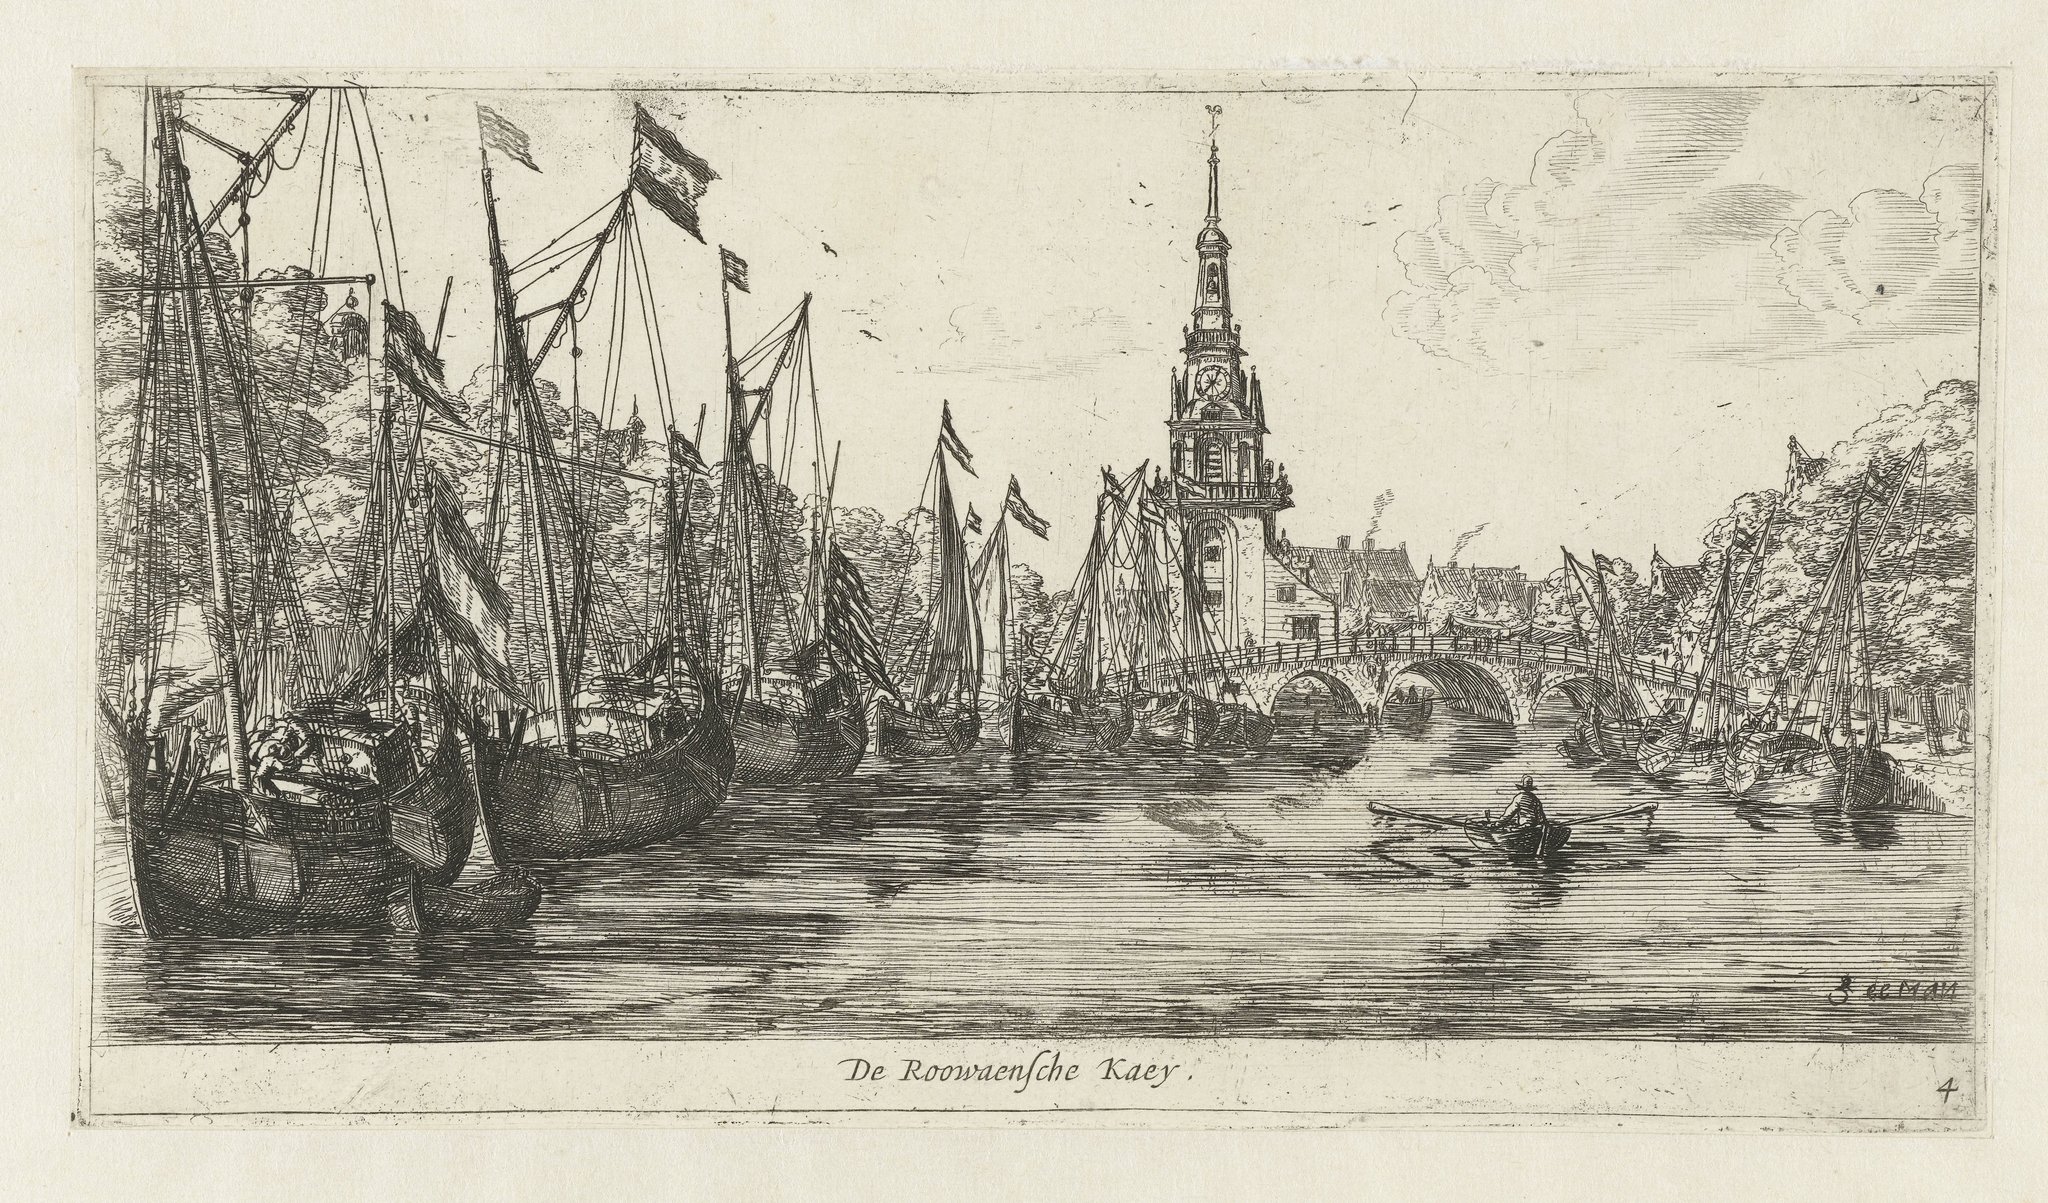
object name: print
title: Rouaanse kaai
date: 1657-1670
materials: paper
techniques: etching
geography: netherlands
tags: city-view in general; 'veduta'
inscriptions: collector's mark: Lugt 240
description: Singel, gezien in zuidelijke richting naar de Jan Rodenpoortstoren en de Torensluis. Links de Rouaanse Kade. Een rij schepen in het water langs de kade.